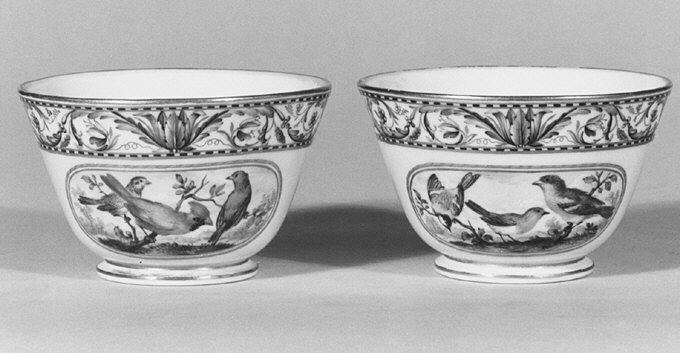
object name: teacup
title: Teacup (part of a service)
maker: meissen manufactory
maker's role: manufactory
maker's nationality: german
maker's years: 1710-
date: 1780-1785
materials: hard paste porcelain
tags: birds